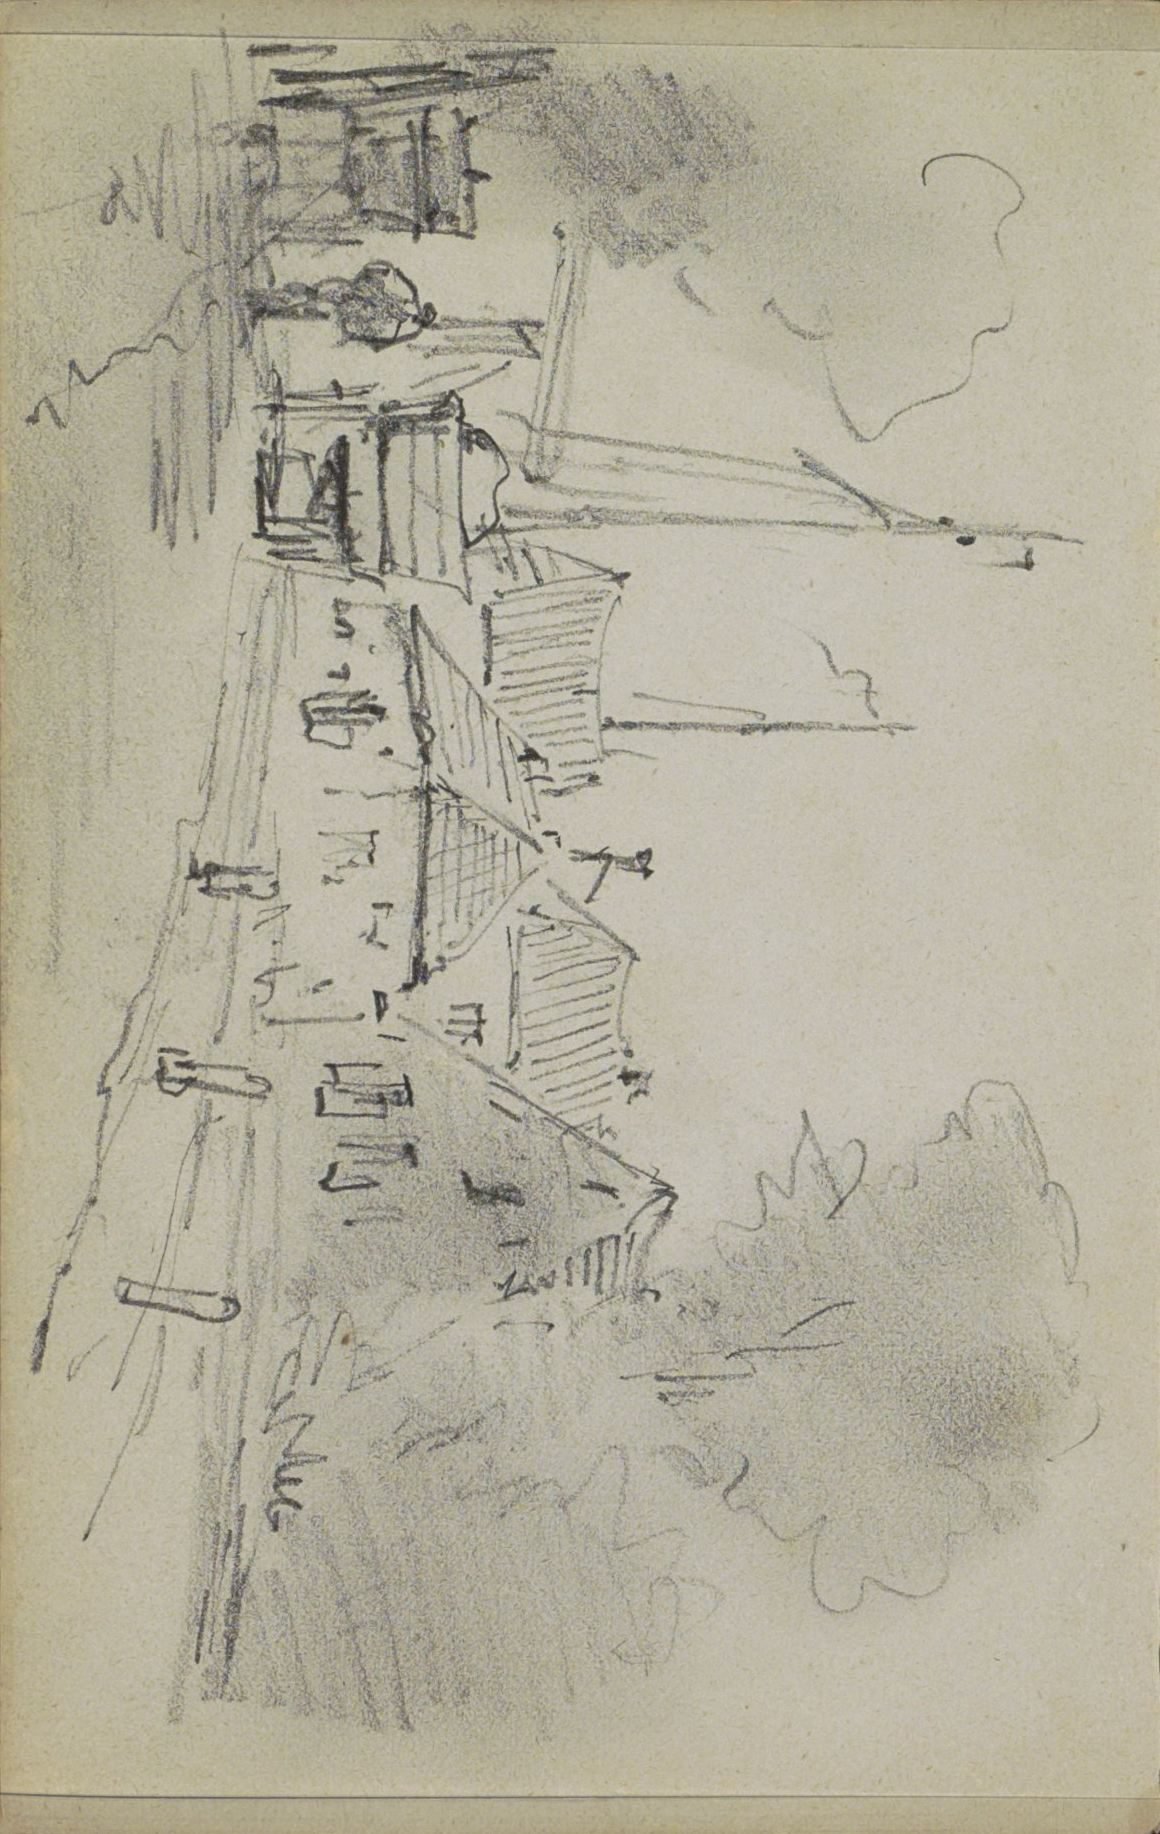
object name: sketchbook leaf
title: Gezicht op gebouwen langs een weg met karren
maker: adrianus eversen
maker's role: draughtsman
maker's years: 1818-1897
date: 1828-1897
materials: paper, pencil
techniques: stumping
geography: netherlands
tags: sailing-ship, sailing-boat, civic architecture; edifices; dwellings, (farm) wagon, freight wagon, cart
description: Links een figuur tussen twee beladen karren. Rechts gebouwen, mogelijk aan het water. In de verte twee masten van zeilschepen. Blad 57 verso uit een schetsboek met 58 bladen.